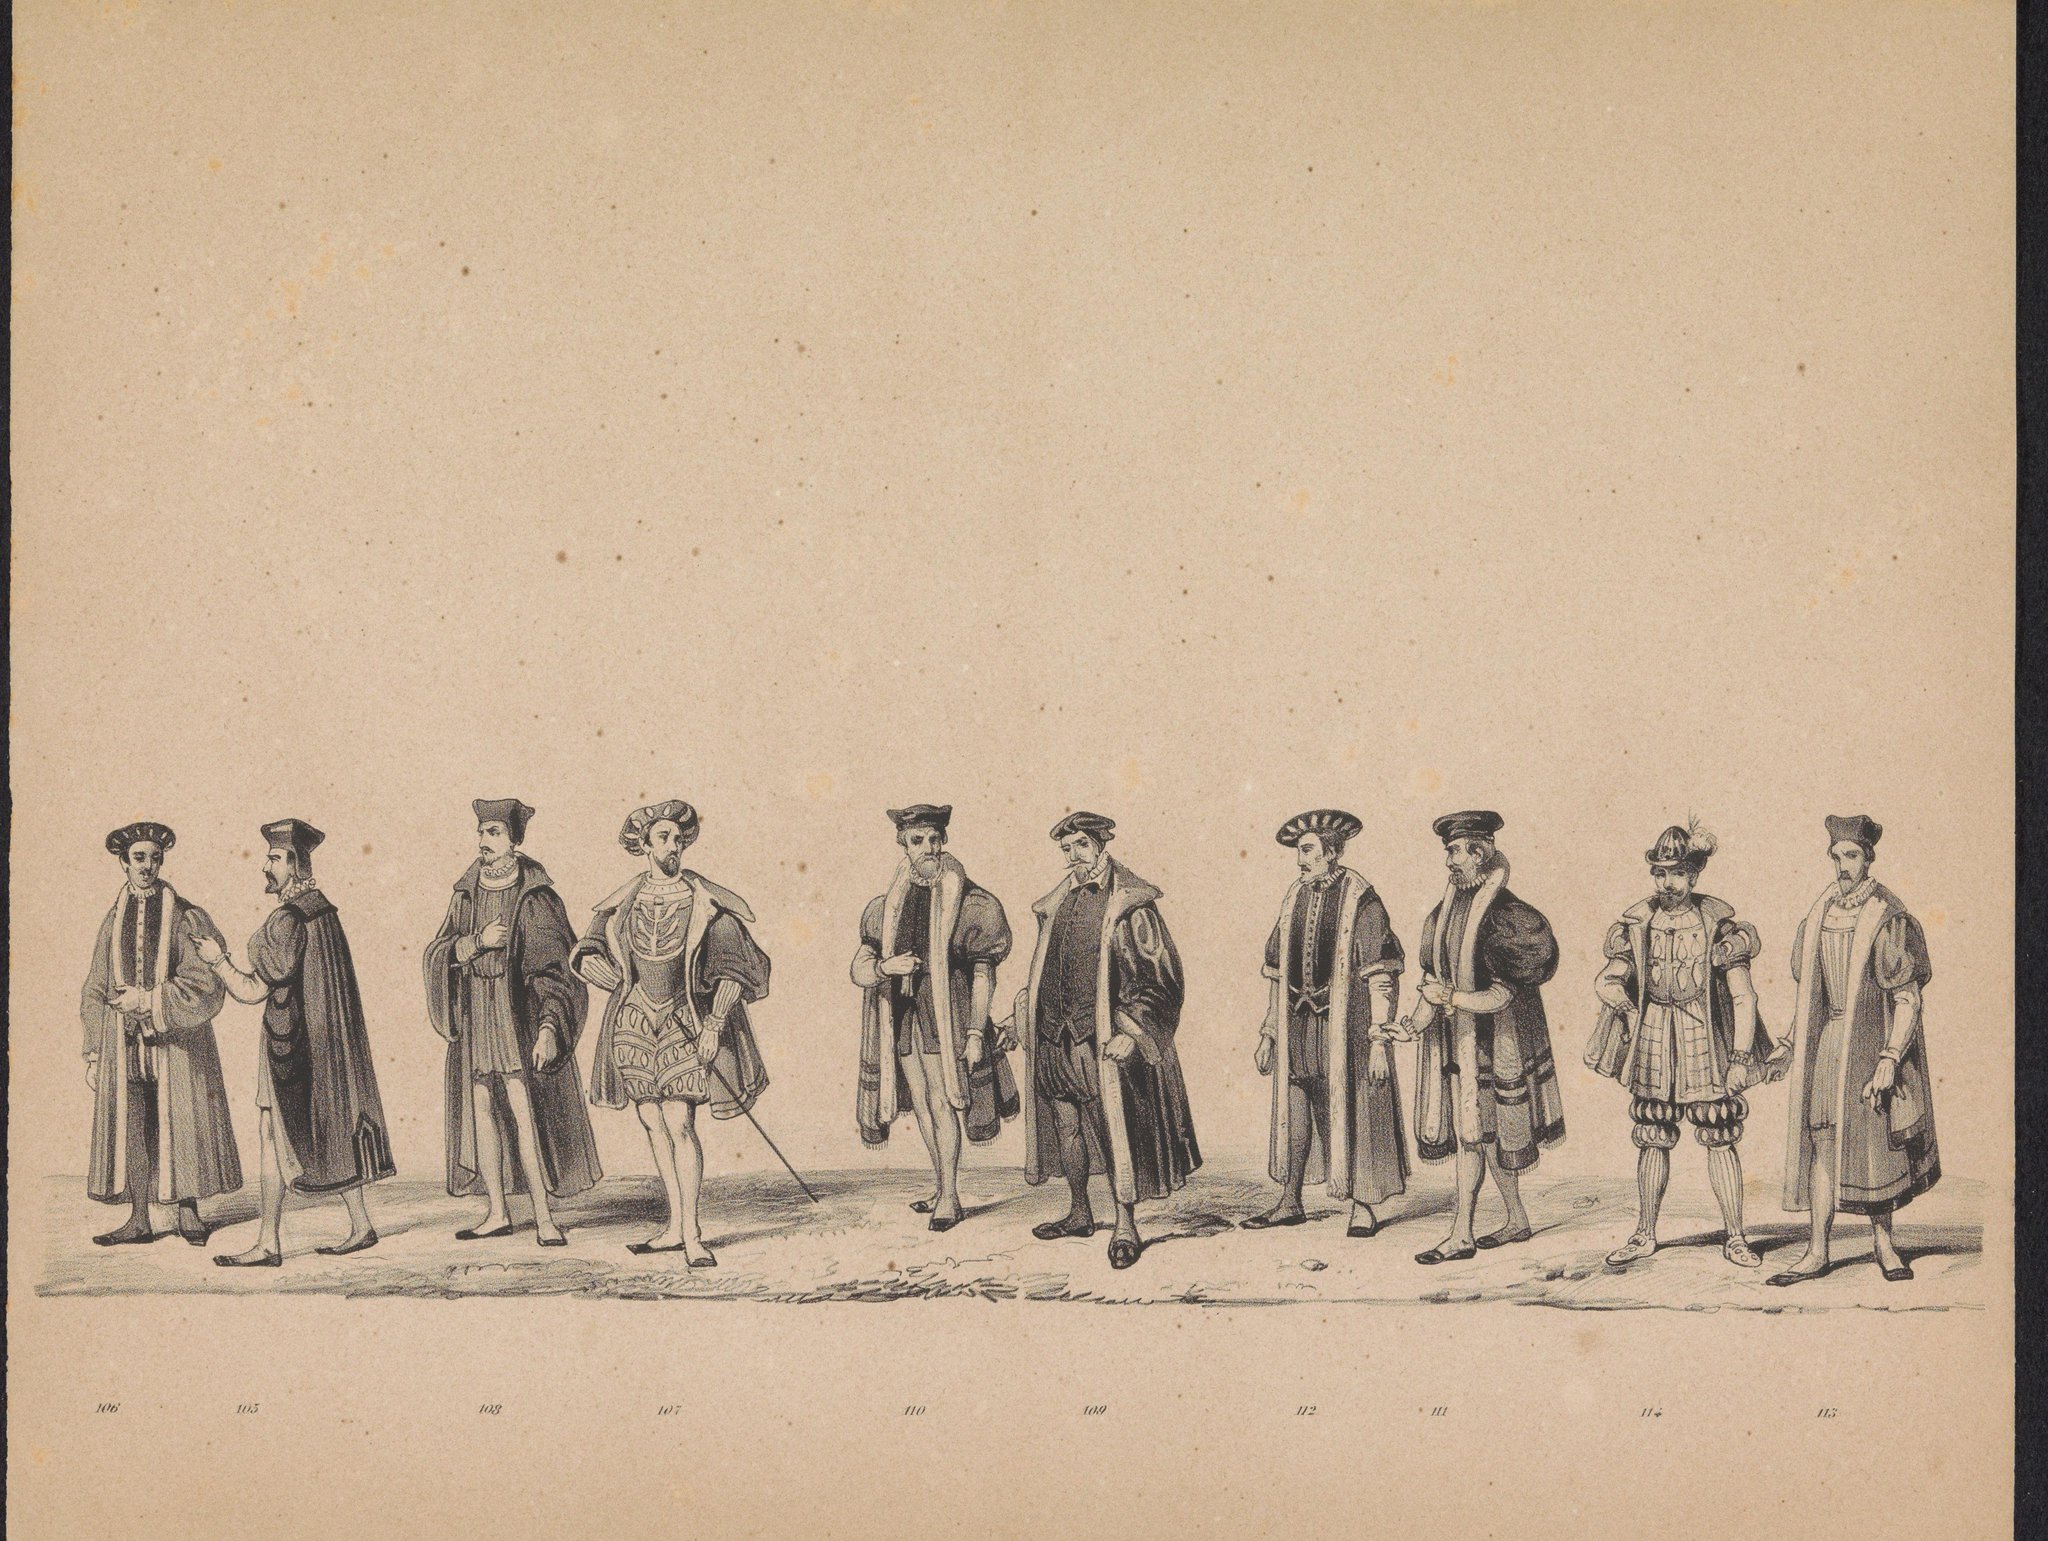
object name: print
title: Maskerade van de Utrechtse studenten, 1846 (plaat 19)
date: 1847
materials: paper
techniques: lithograph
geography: netherlands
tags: philip ii of spain, students' pageant, costumes used in pageants, utrecht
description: Historische gekostumeerde optocht van de studenten van de Utrechtse Hogeschool gehouden op 17 juni 1846 ter gelegenheid van het 210-jarig bestaan van de Hogeschool. De optocht verbeeldt de intocht van Filips II in Utrecht op 3 oktober 1549. Plaat met de groepen genummerd 105-114. Onderdeel van de serie van 22 aanelkaar te plakken losse bladen.